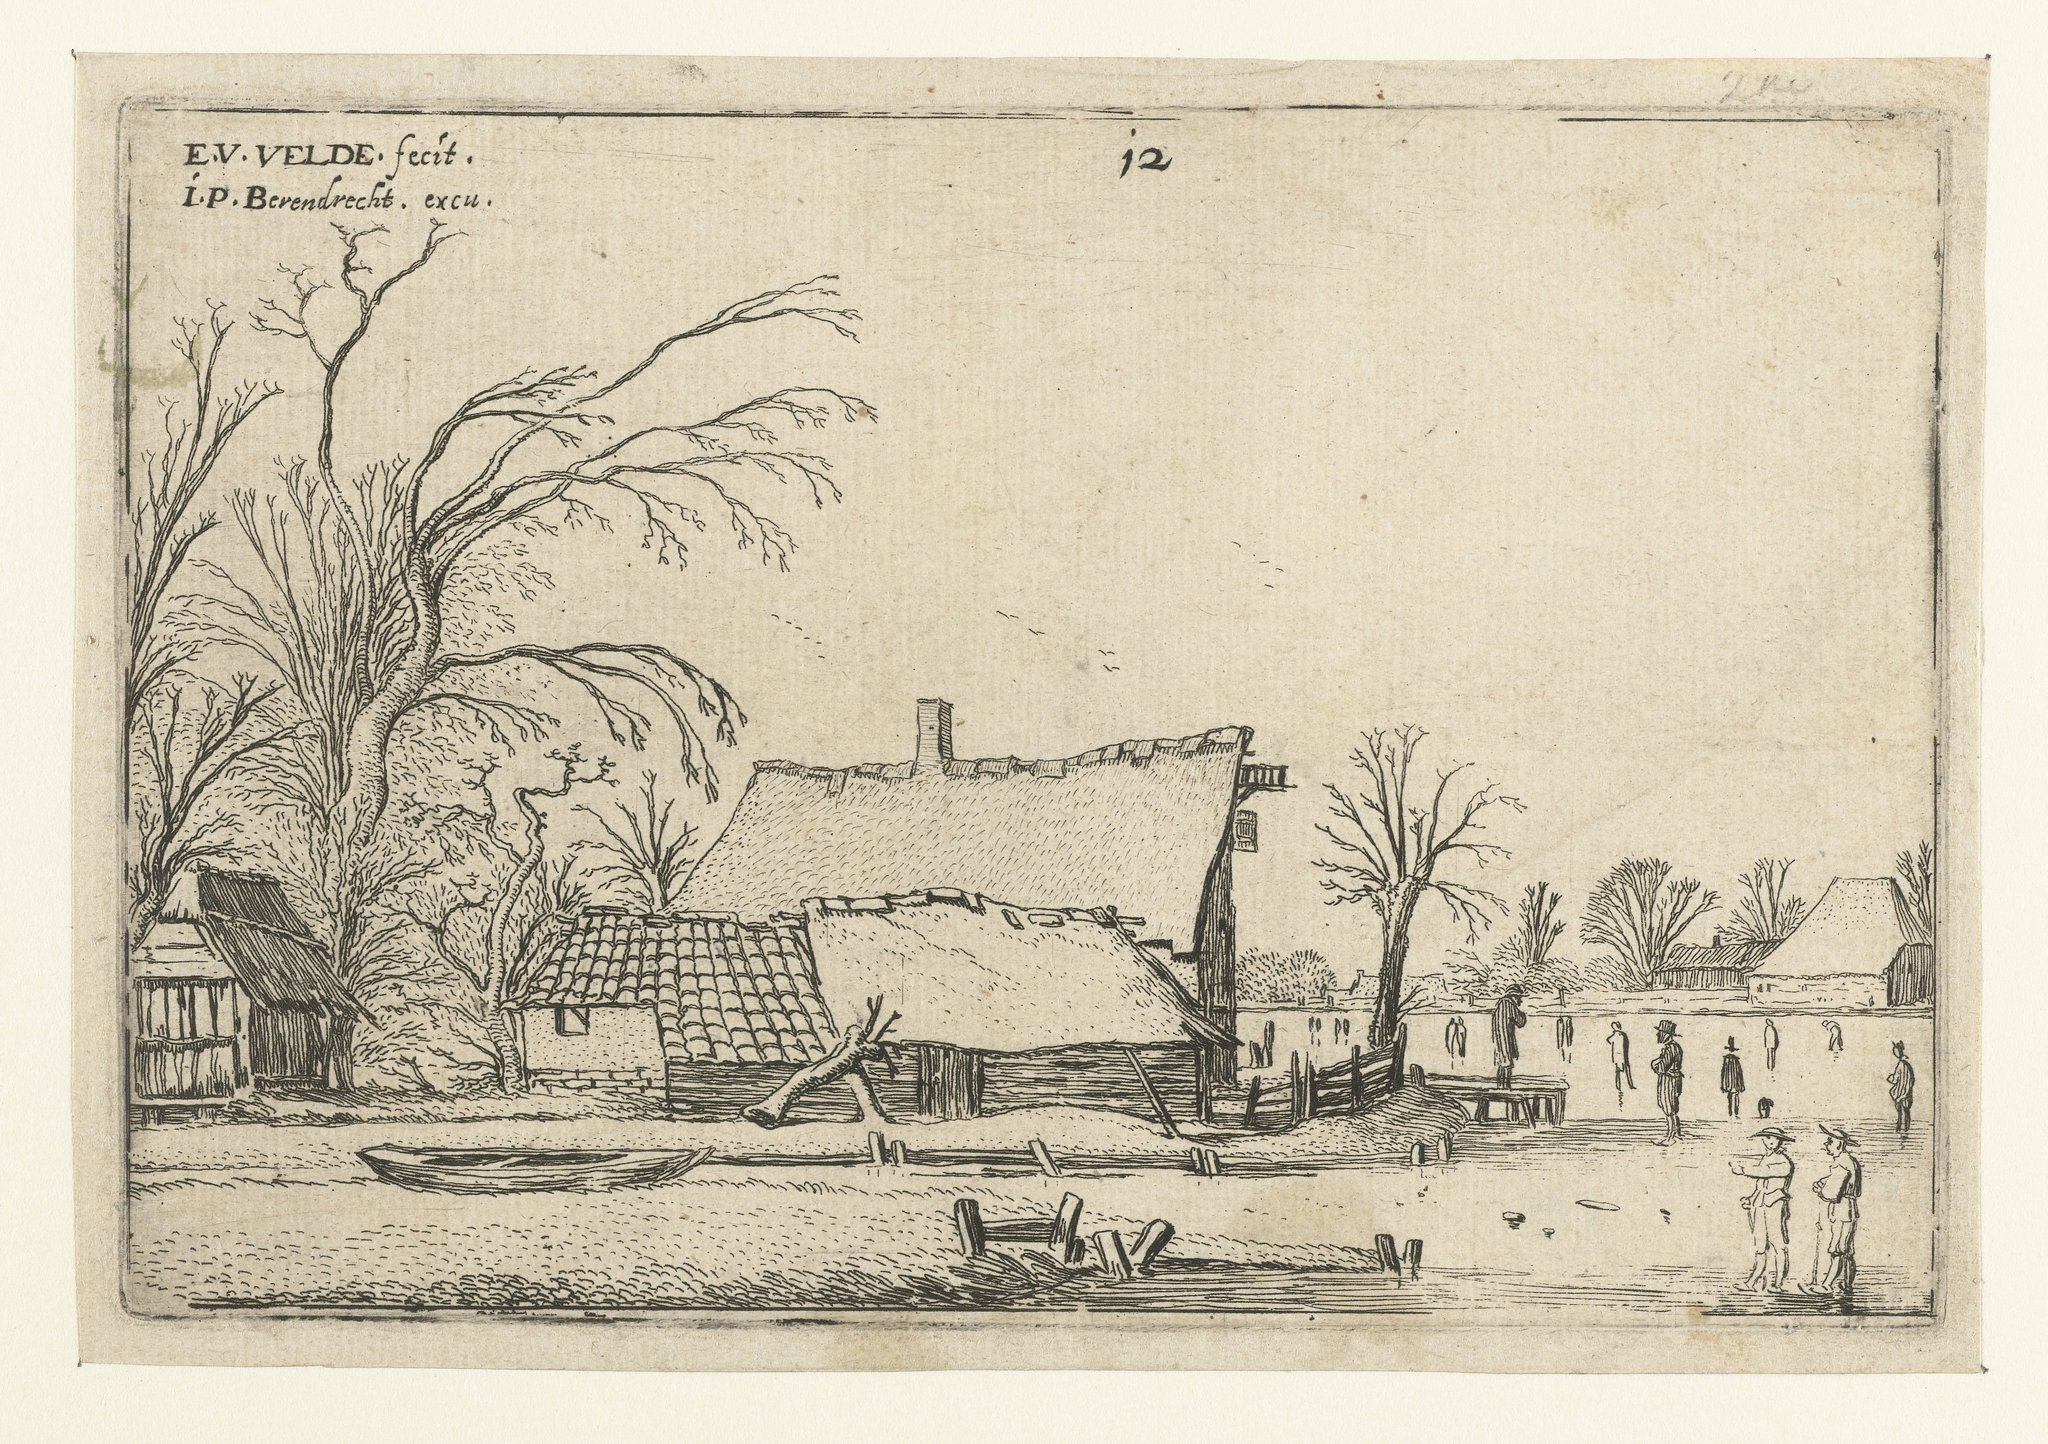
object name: print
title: Boerderij bij een bevroren rivier met schaatsers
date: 1616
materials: paper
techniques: etching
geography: haarlem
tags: skates (winter sports), farm or solitary house in landscape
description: Mogelijk werd deze prent op een bepaald moment door de uitgever Berendrecht aan de serie van tien landschappen toegevoegd. De wijziging van het nummer, 12 in plaats van 4, houdt hiermee misschien verband.